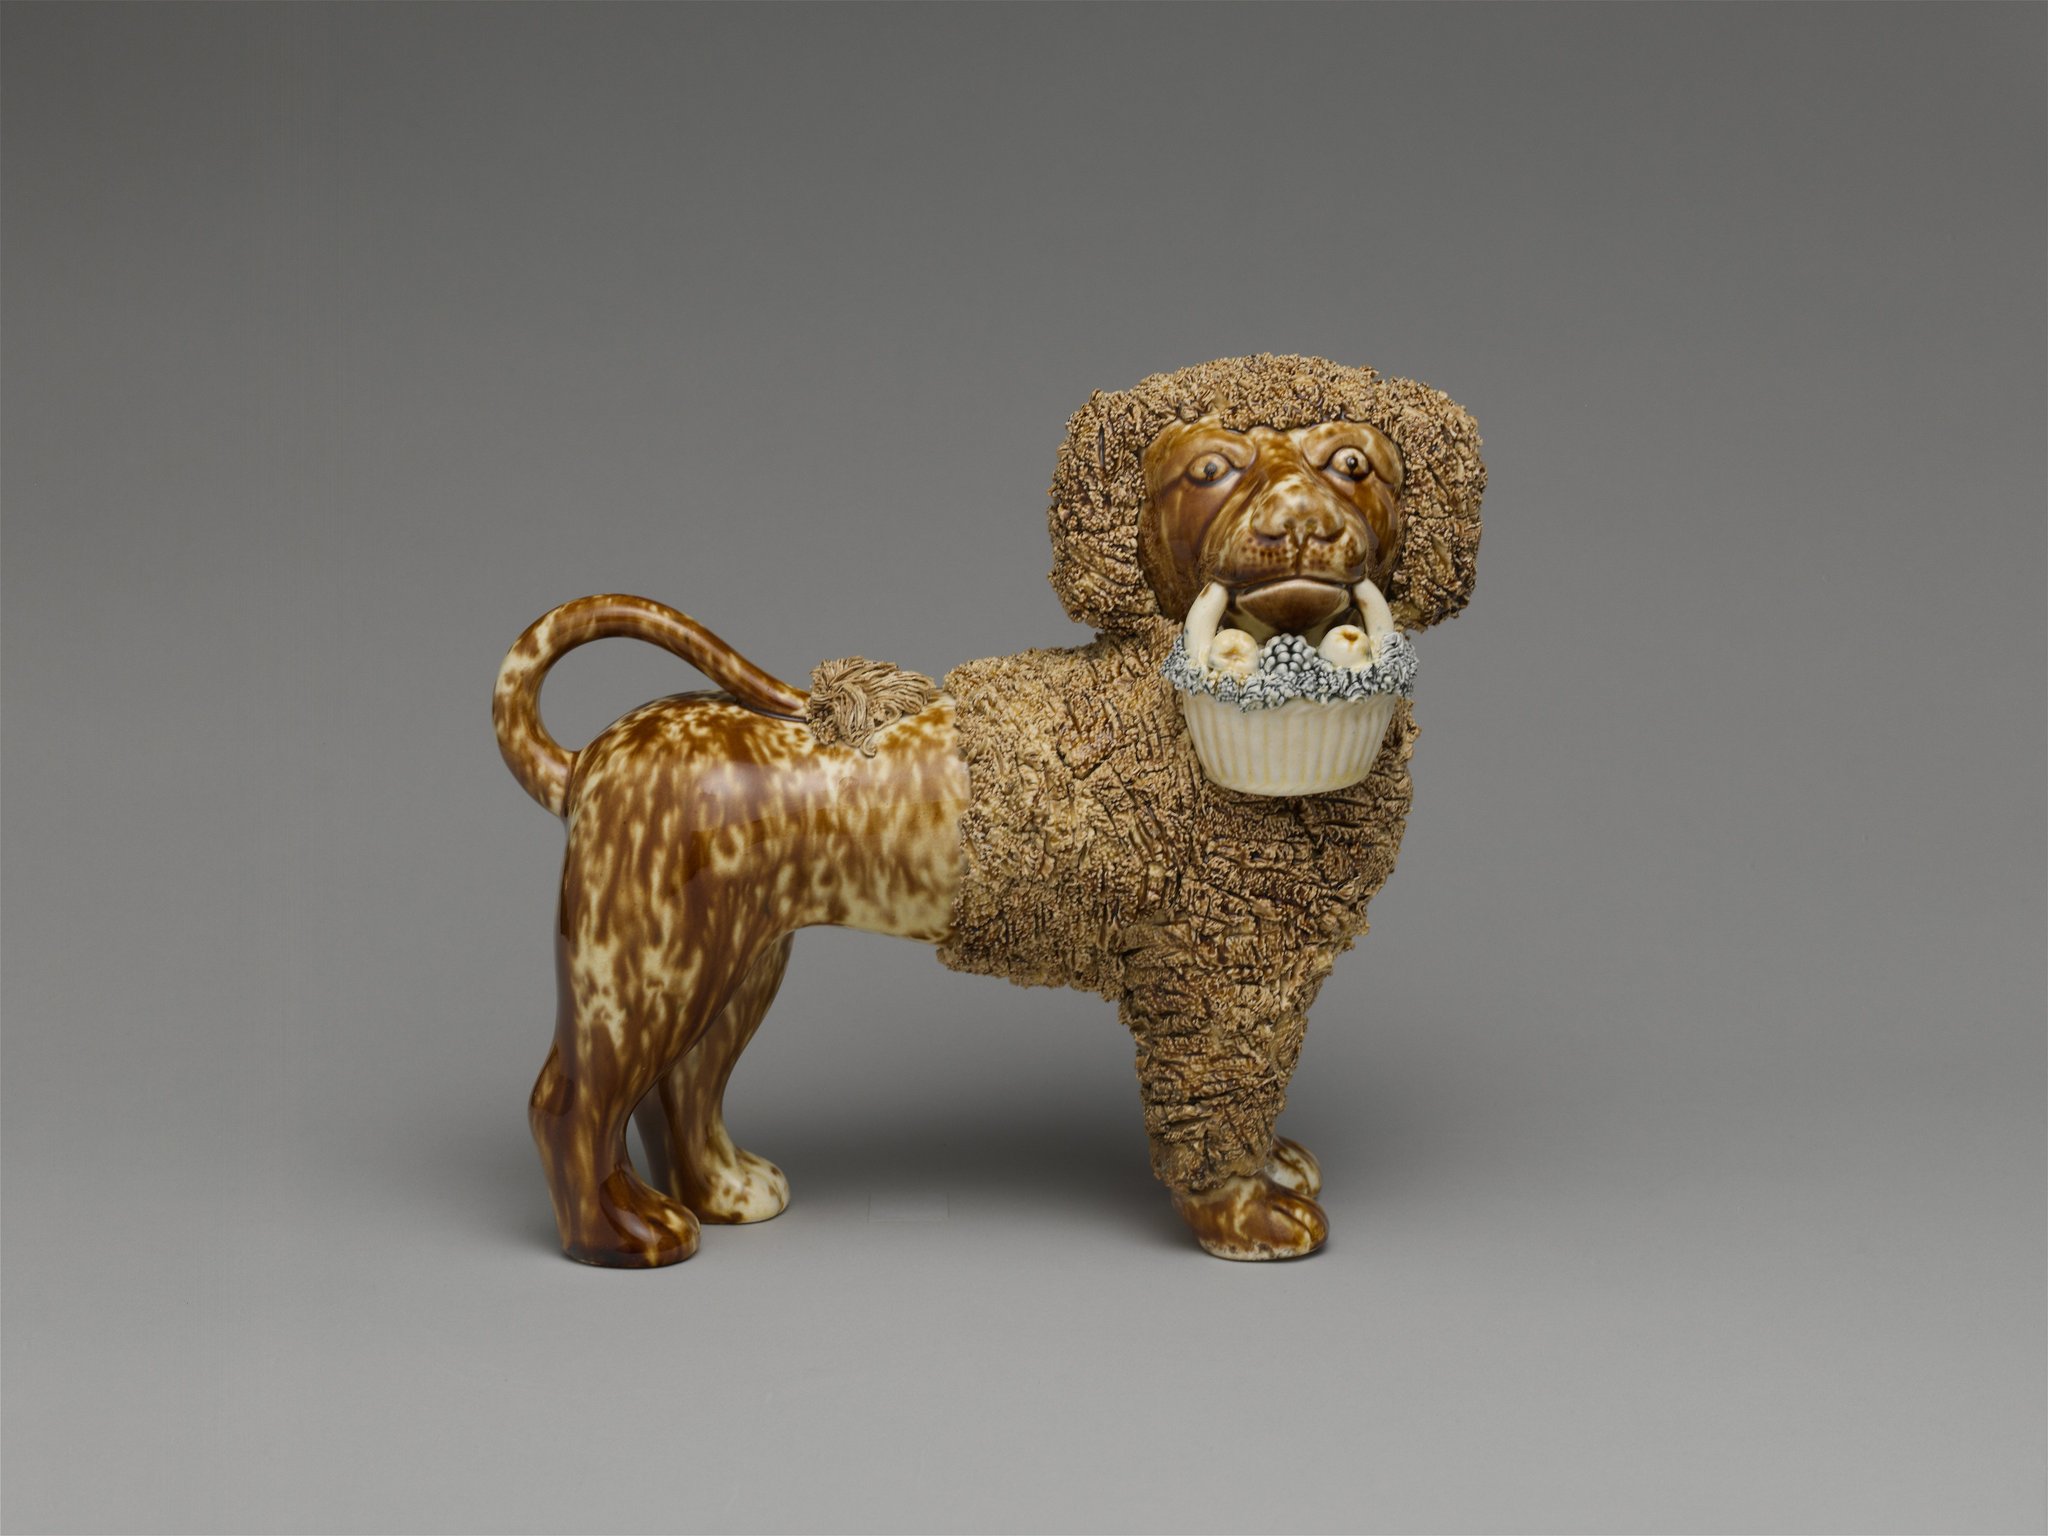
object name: figure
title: Standing poodle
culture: american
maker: united states pottery company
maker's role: manufacturer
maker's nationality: american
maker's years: 1852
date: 1849-1858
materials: earthenware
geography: united states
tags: dogs